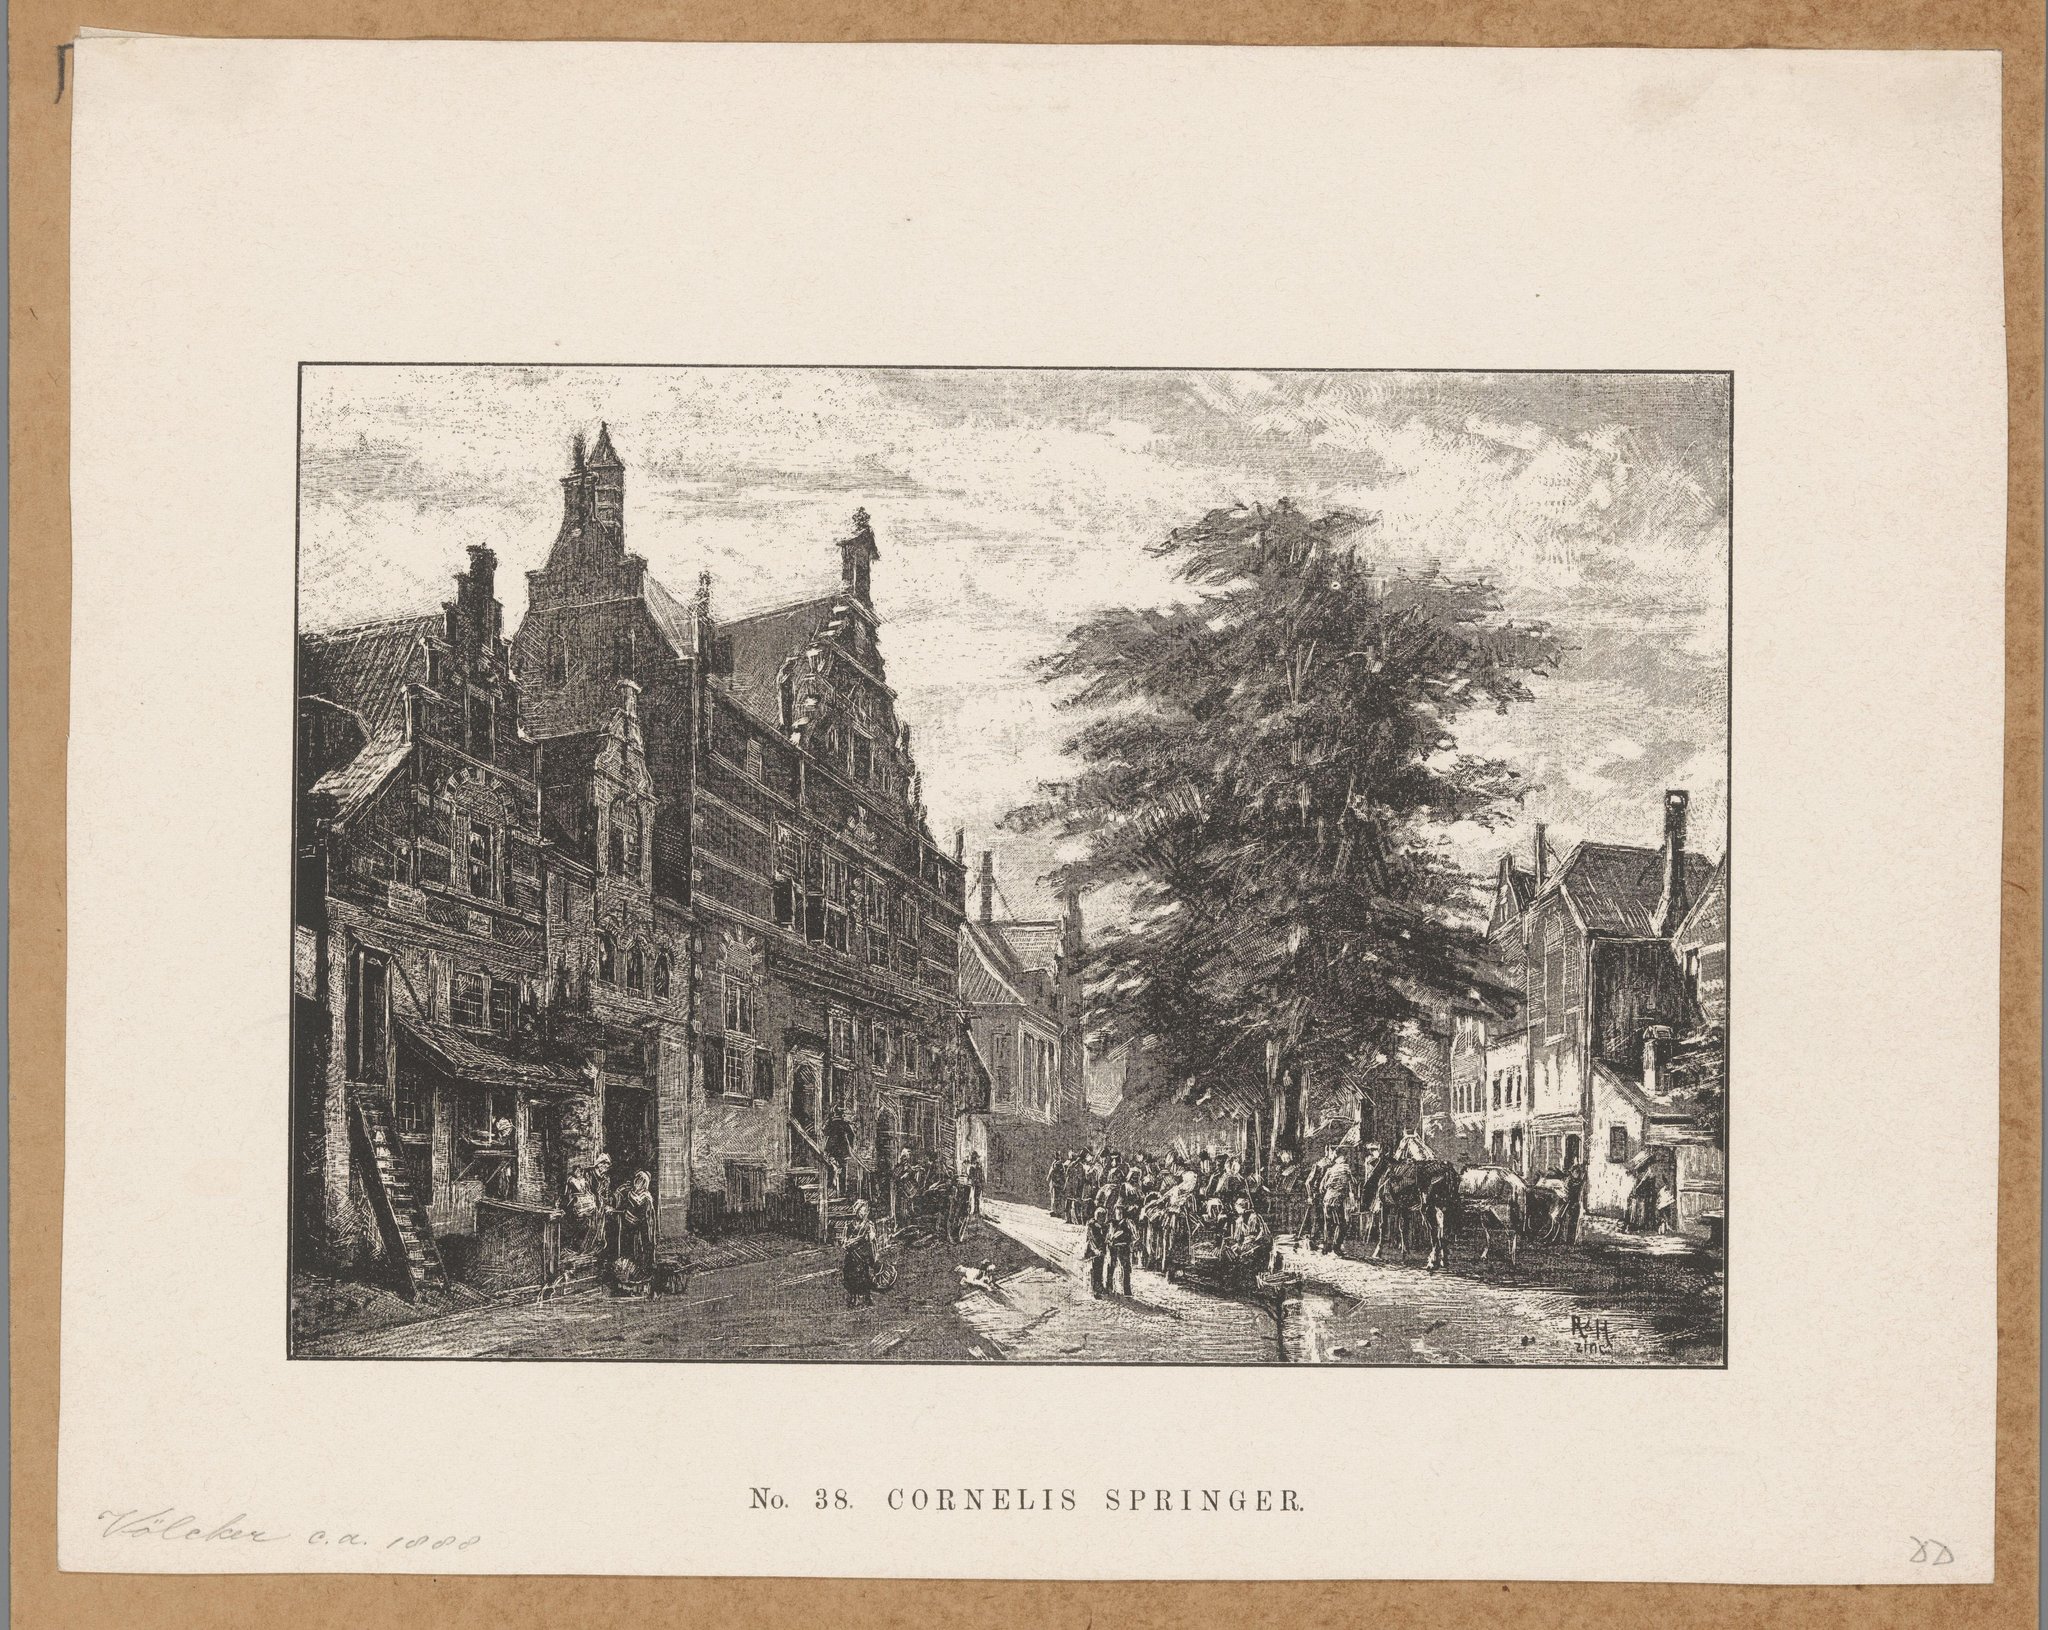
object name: photomechanical print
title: Gezicht op de kaasmarkt en de Waag in Enkhuizen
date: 1888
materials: paper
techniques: autotype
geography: enkhuizen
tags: market, weigh-house, village street (+ city(-scape) with figures, staffage)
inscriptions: collector's mark: Lugt 2228